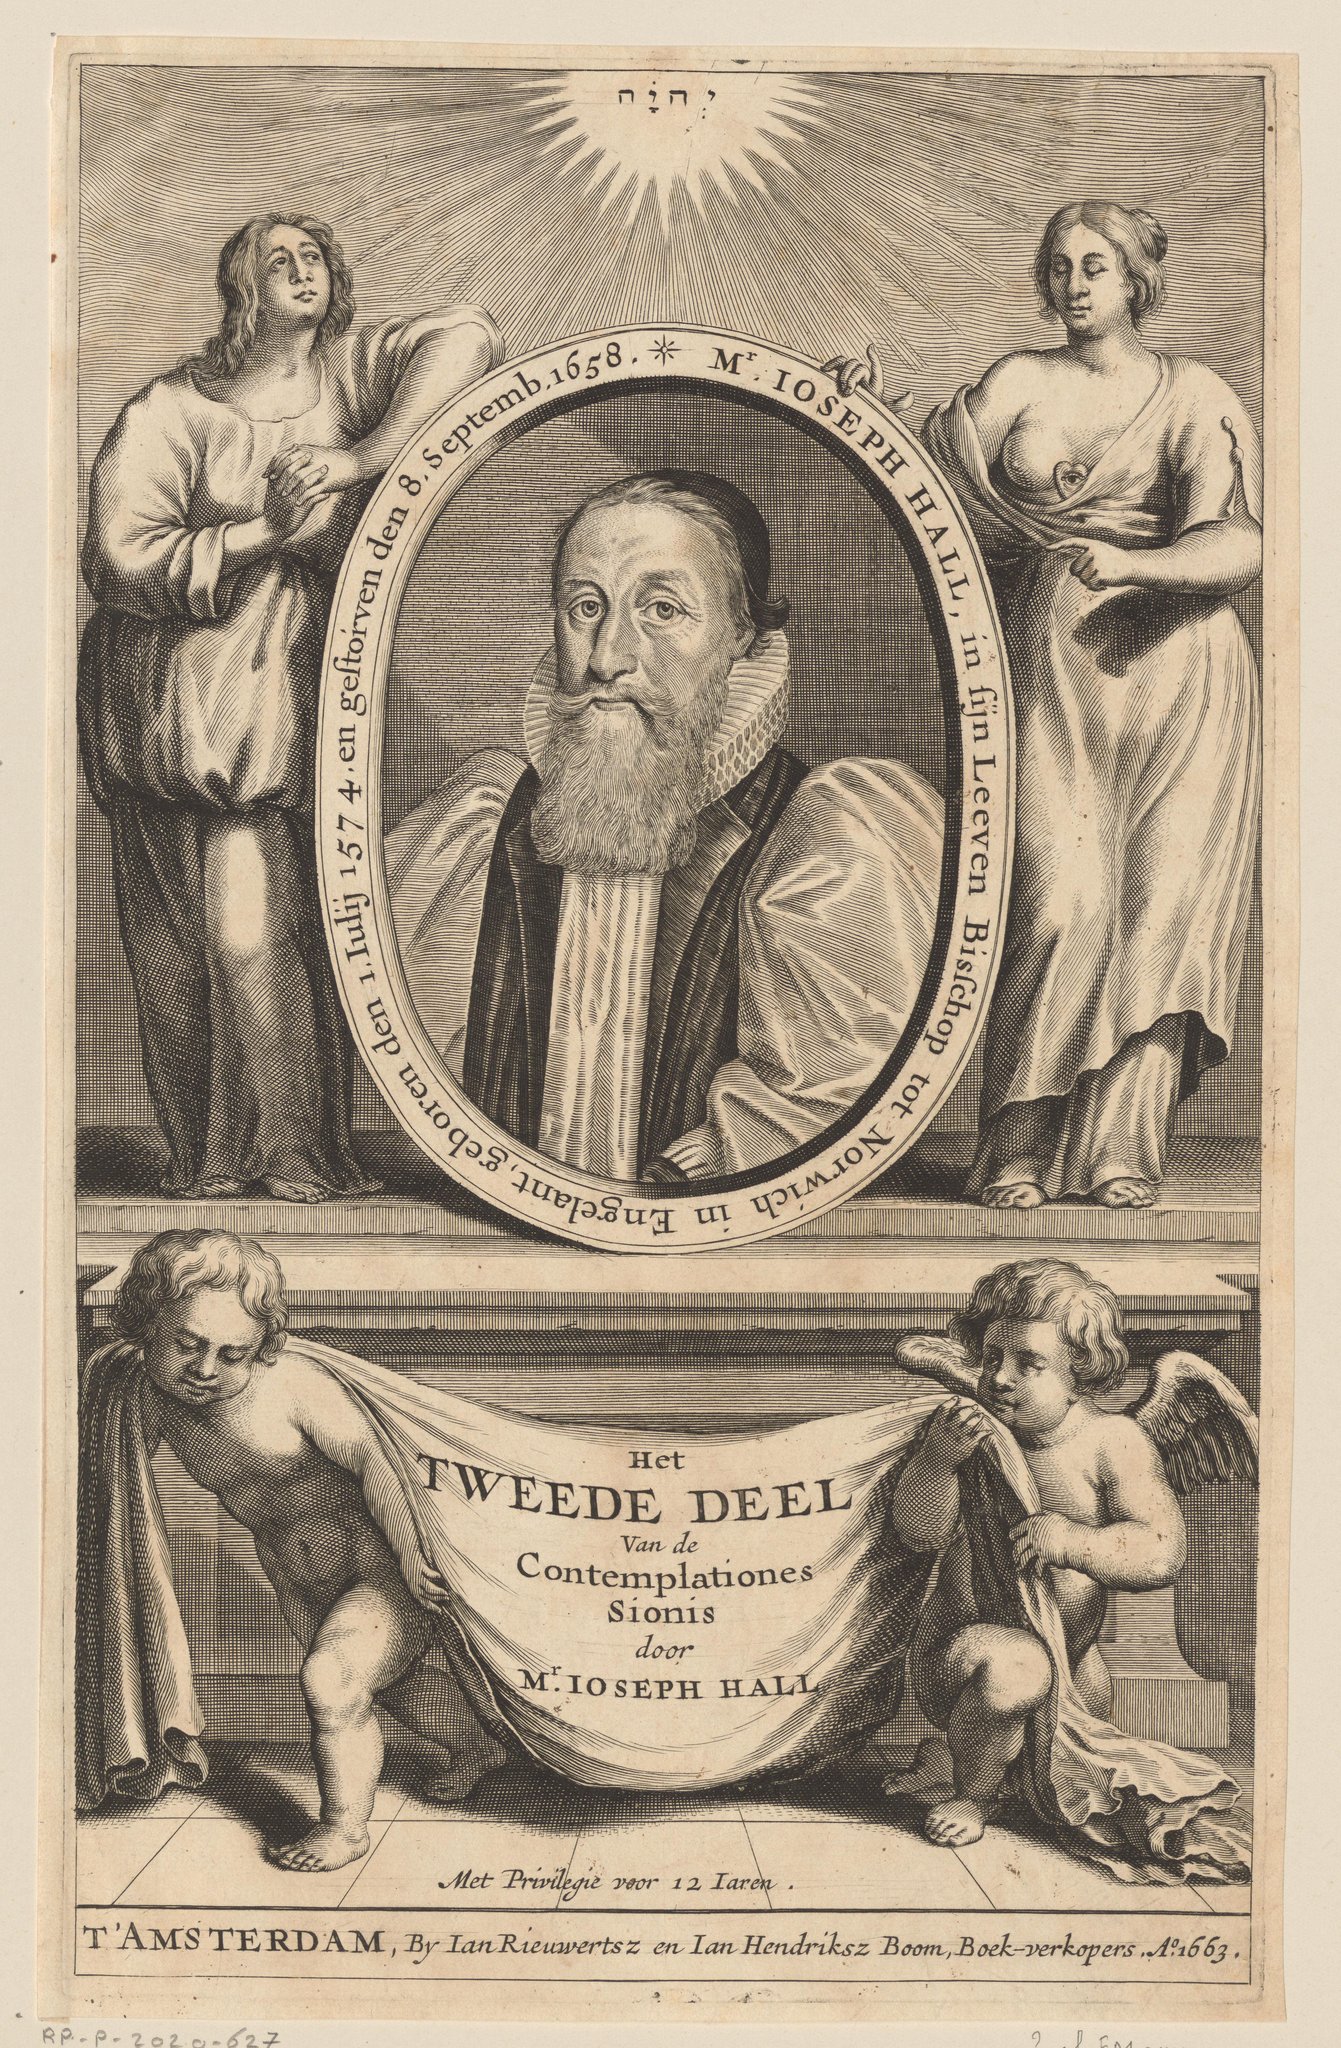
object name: titelblad, titelpagina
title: Portret van Joseph Hall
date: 1663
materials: paper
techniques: engraving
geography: amsterdam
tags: faith, 'fides'; 'fede', 'fede catholica', 'fede christiana', 'fede christiana catholica' (ripa) ~ one of the three theological virtues, theologian, historical persons, cupids: 'amores', 'amoretti', 'putti'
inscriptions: date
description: Titelpagina voor: Hall, Joseph. Contemplationes Sionis, of: heylige bedenckingen, bestaende in stichtelijcke tractaten (...). Amsterdam: Jan Hendricksz. Boom en Jan Rieuwertsz. (I), 1663, dl. 2.